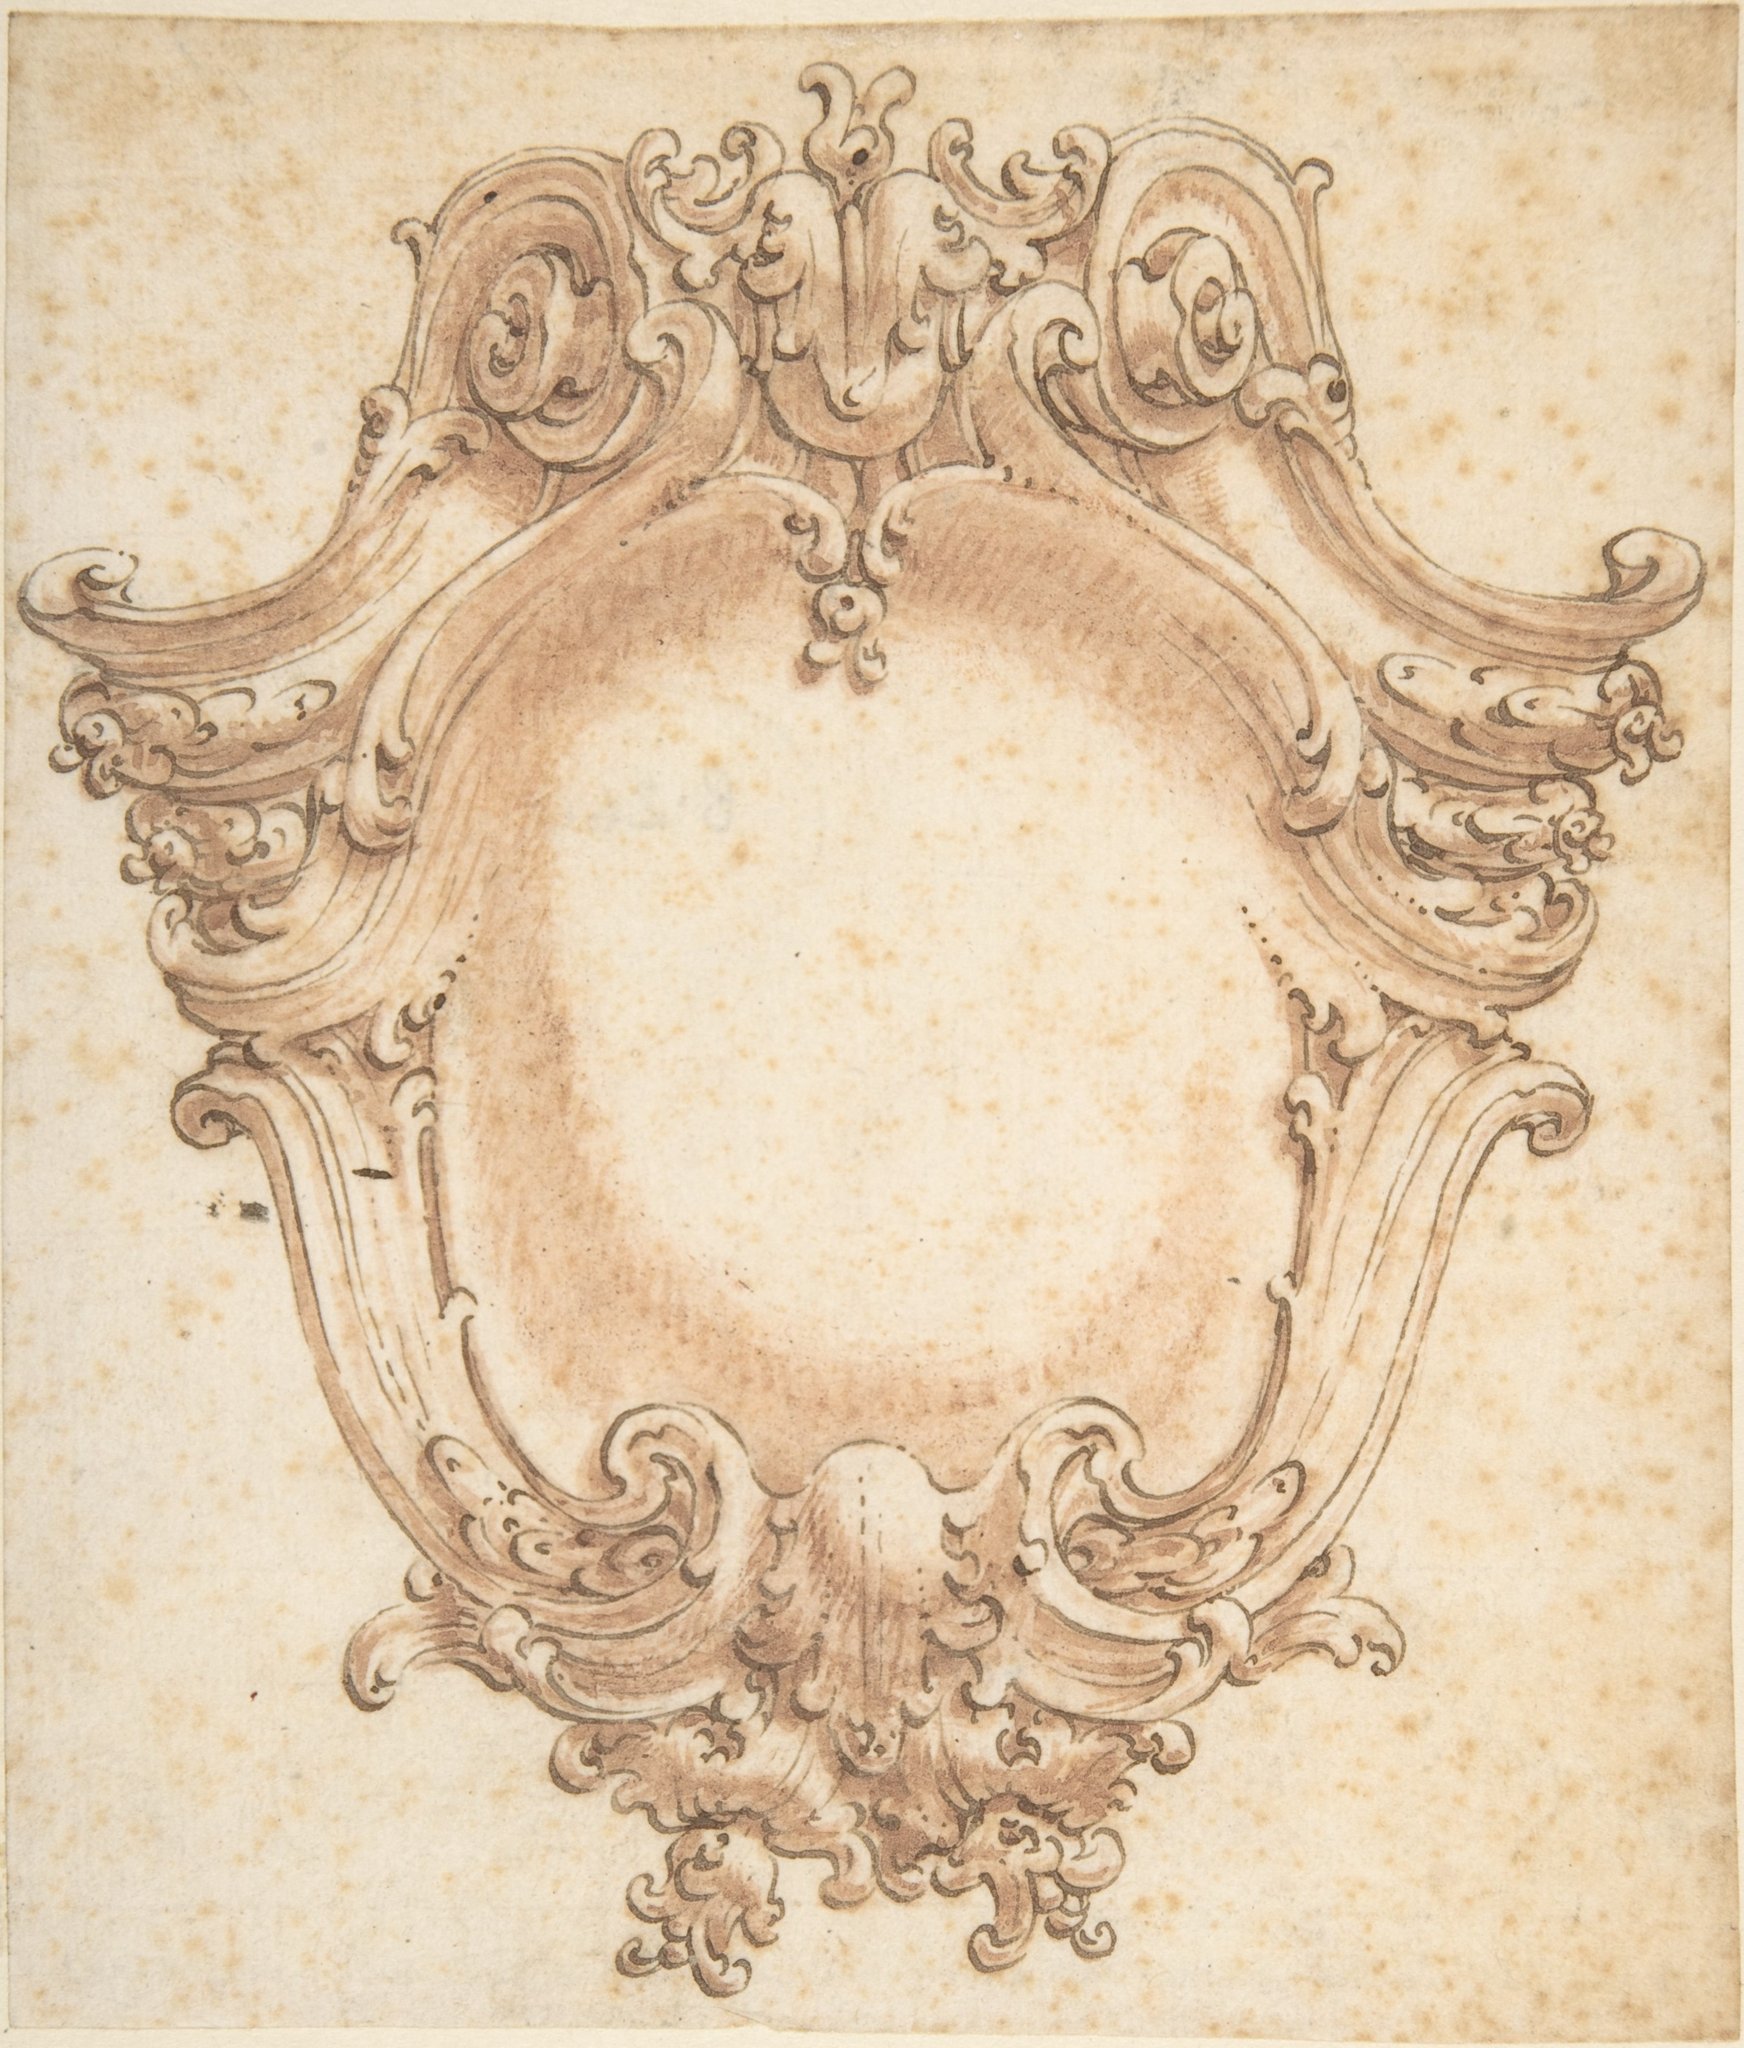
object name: drawing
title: Design for a Cartouche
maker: anonymous, italian, 17th or 18th century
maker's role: artist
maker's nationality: italian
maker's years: 1600-1799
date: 1601-1800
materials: ink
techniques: brush, pen, wash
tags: cartouches